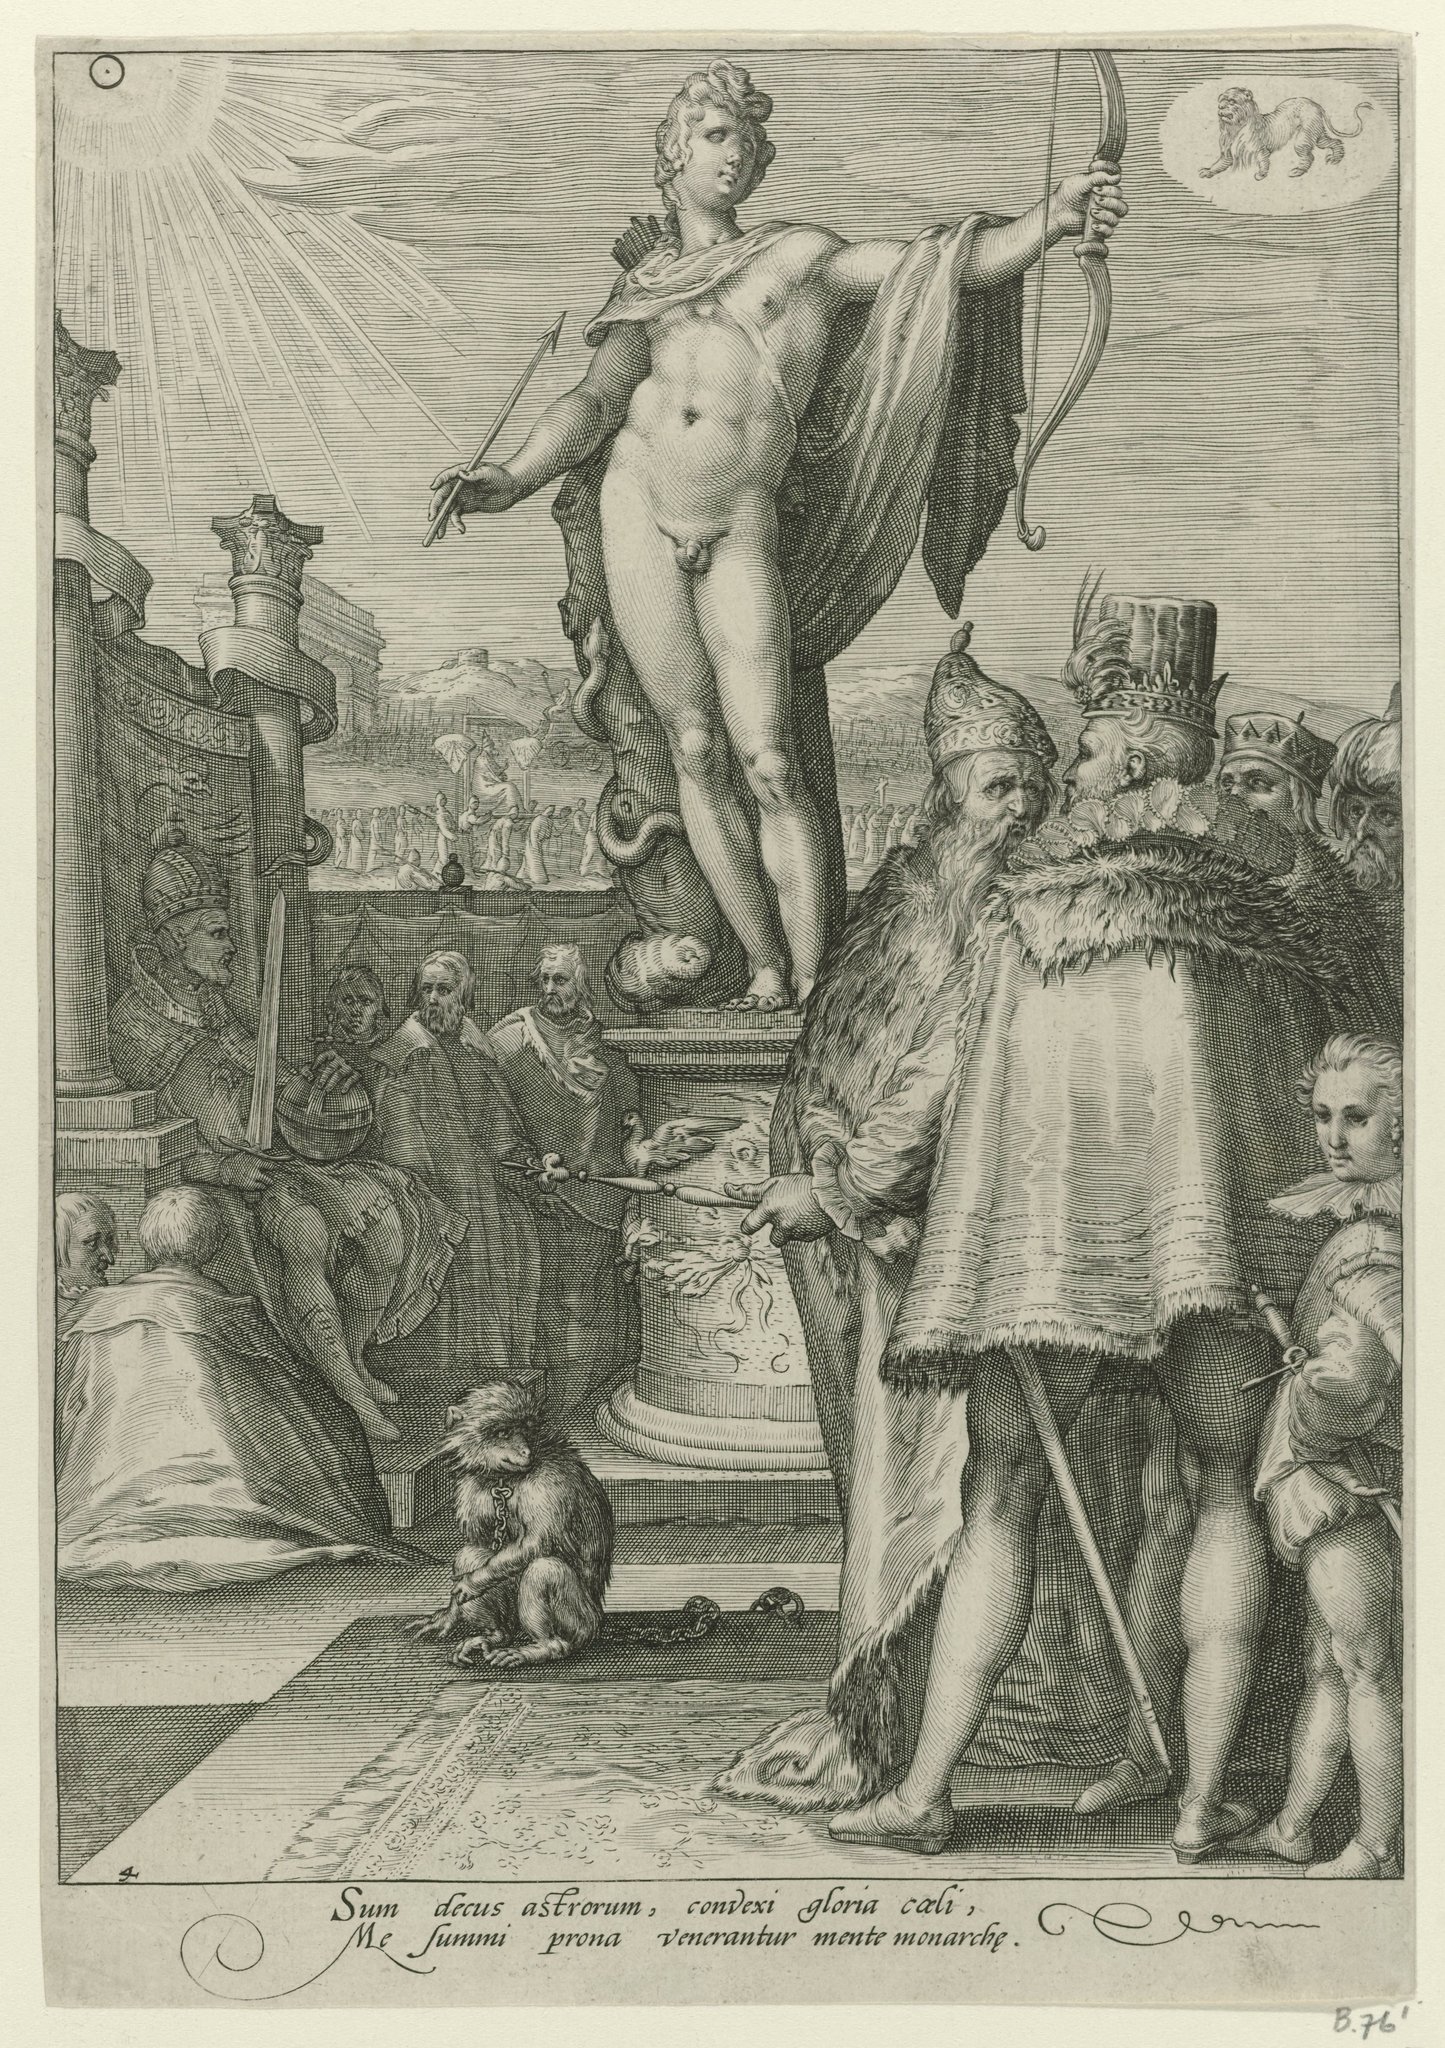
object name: print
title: Apollo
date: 1596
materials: paper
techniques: engraving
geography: northern netherlands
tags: ruler with counsellor(s), (story of) apollo (phoebus), monkeys, apes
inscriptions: collector's mark: Lugt 240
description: Te midden van verschillende regeerders staat de naakte Apollo als heerser over de regeringskunsten op een sokkel. Hij houdt een pijl en boog in zijn handen en steunt tegen een stam waarlangs een slang omhoog kronkelt. Rondom Apollo hebben zich verschillende regeerders met hun raadgevers verzameld. Midden op de voorgrond zit een vastgeketend aapje. Rechts in de lucht het symbool van het sterrenbeeld leeuw.